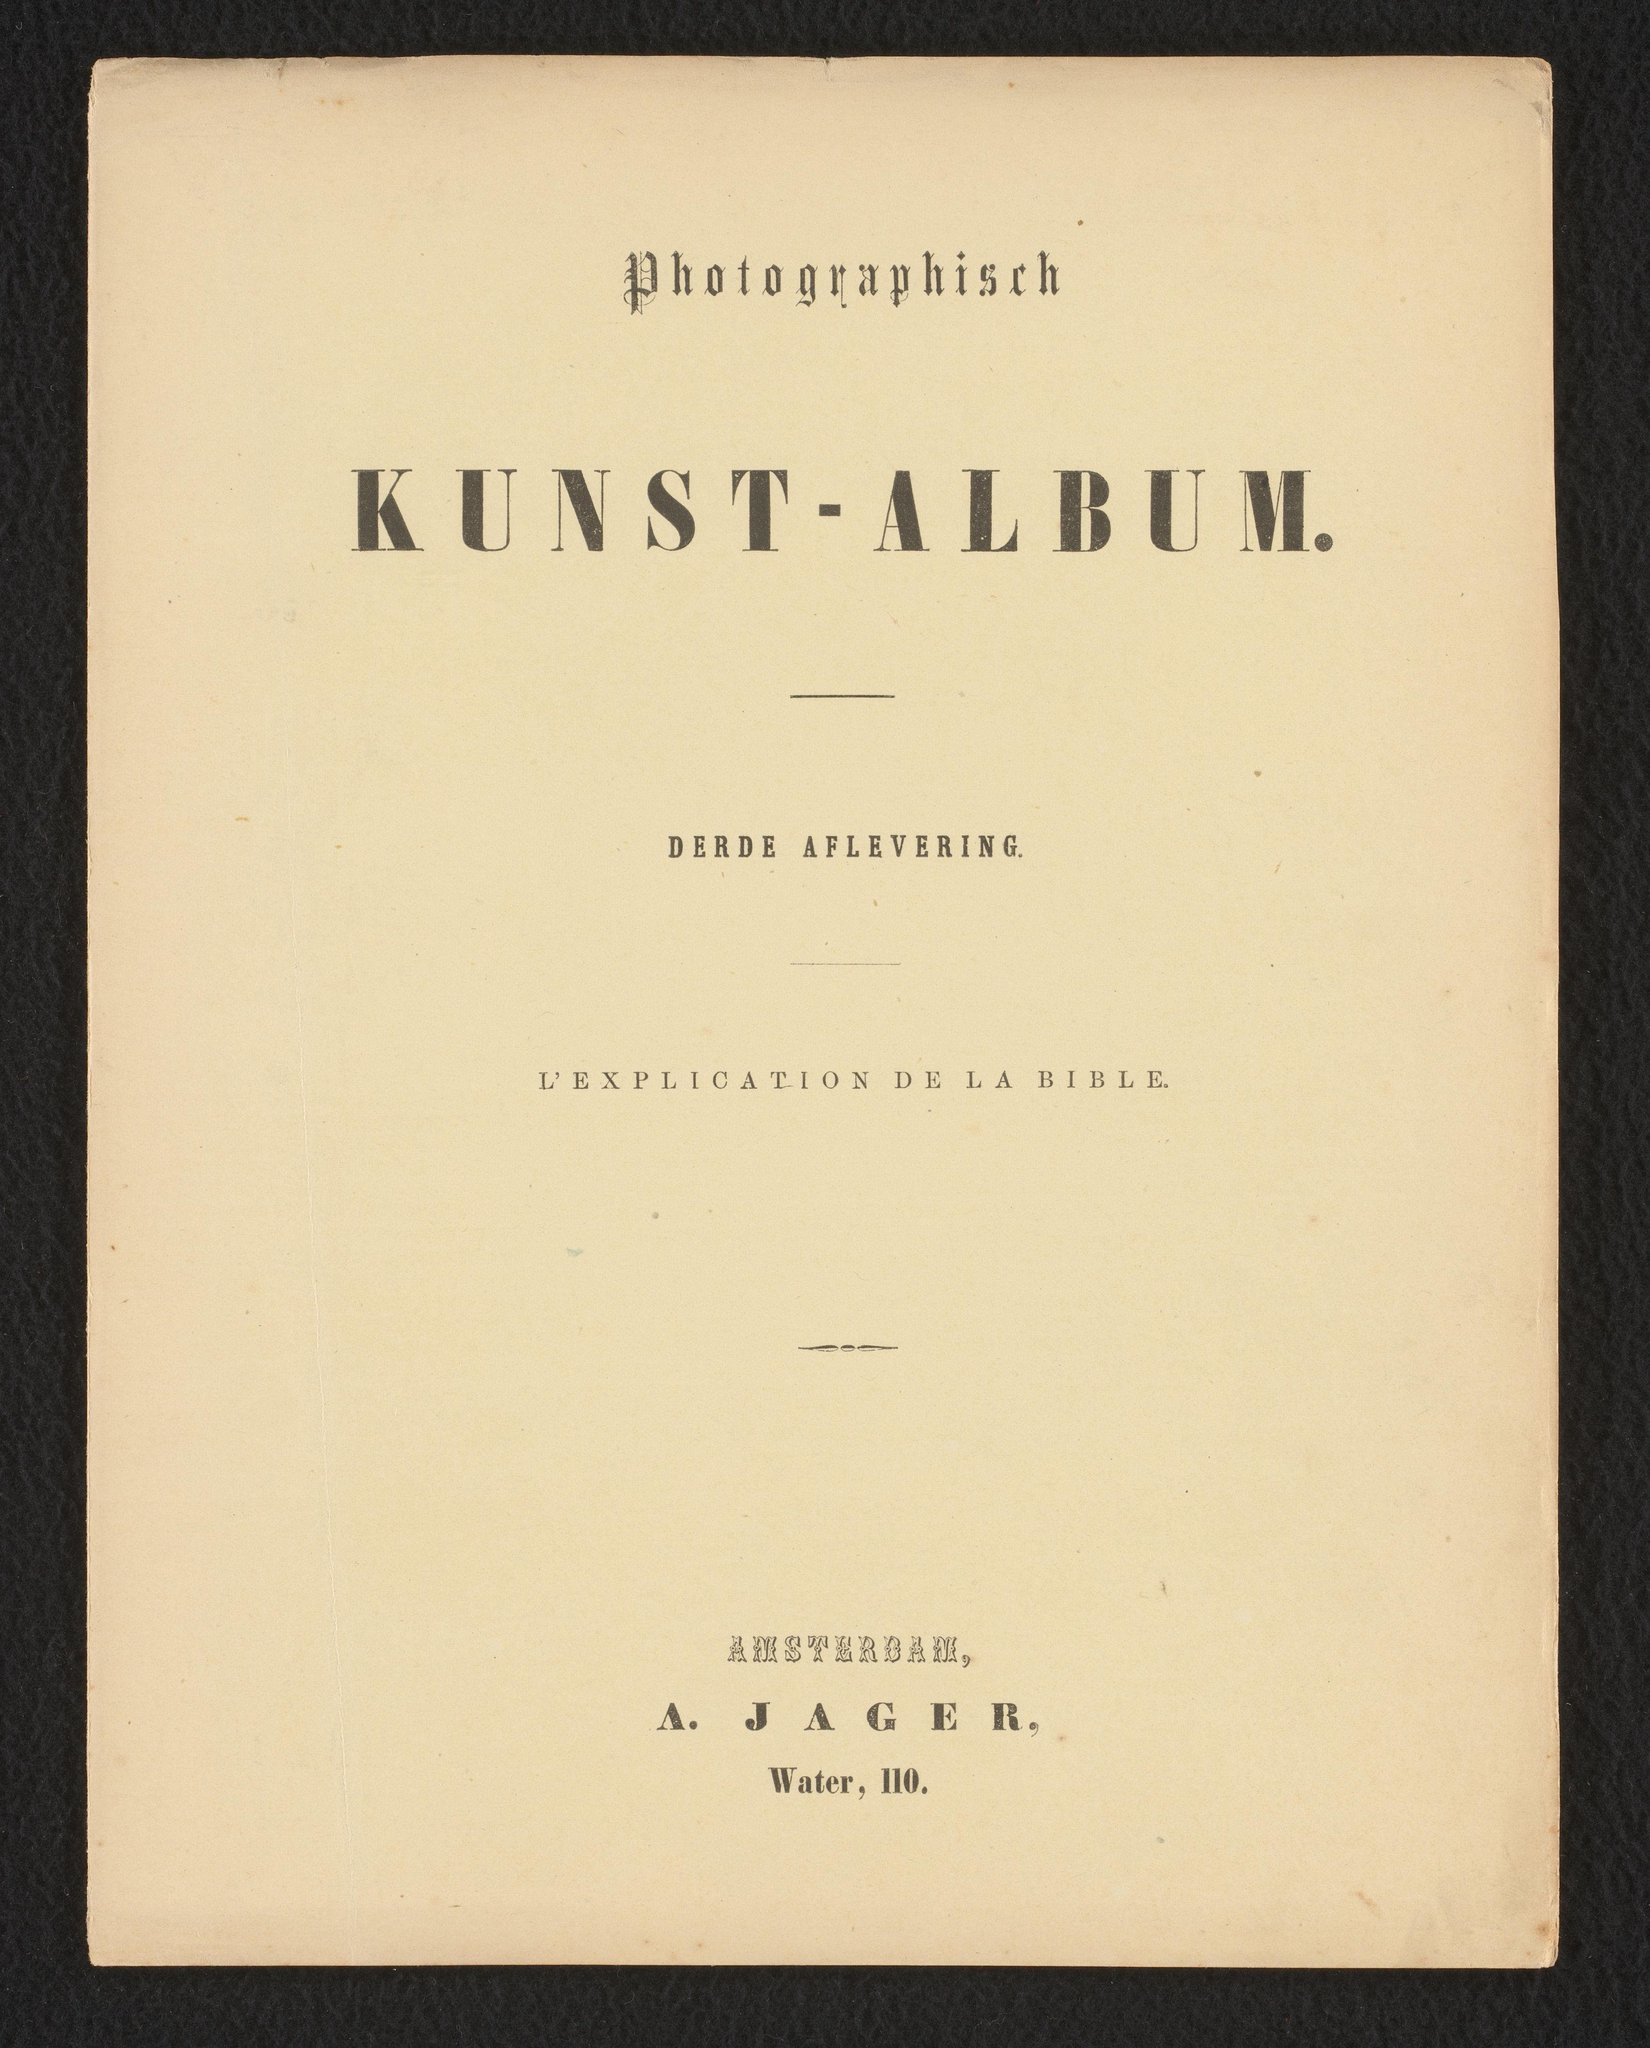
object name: wrapper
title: Omslag voor een fotoreproductie van het schilderij l'Explication de la Bible naar Hunin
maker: andries jager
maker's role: publisher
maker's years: 1825-1905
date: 1860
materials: paper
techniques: printing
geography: amsterdam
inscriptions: address: ‘AMSTERDAM,/ A. JAGER,/ Water, 110.’, inscription: ‘L'EXPLICATION DE LA BIBLE./ NAAR EENE SCHILDERIJ/ VAN/ HUNIN.’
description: Deze omslag maakt deel uit van een omslag met twaalf fotoreproducties.